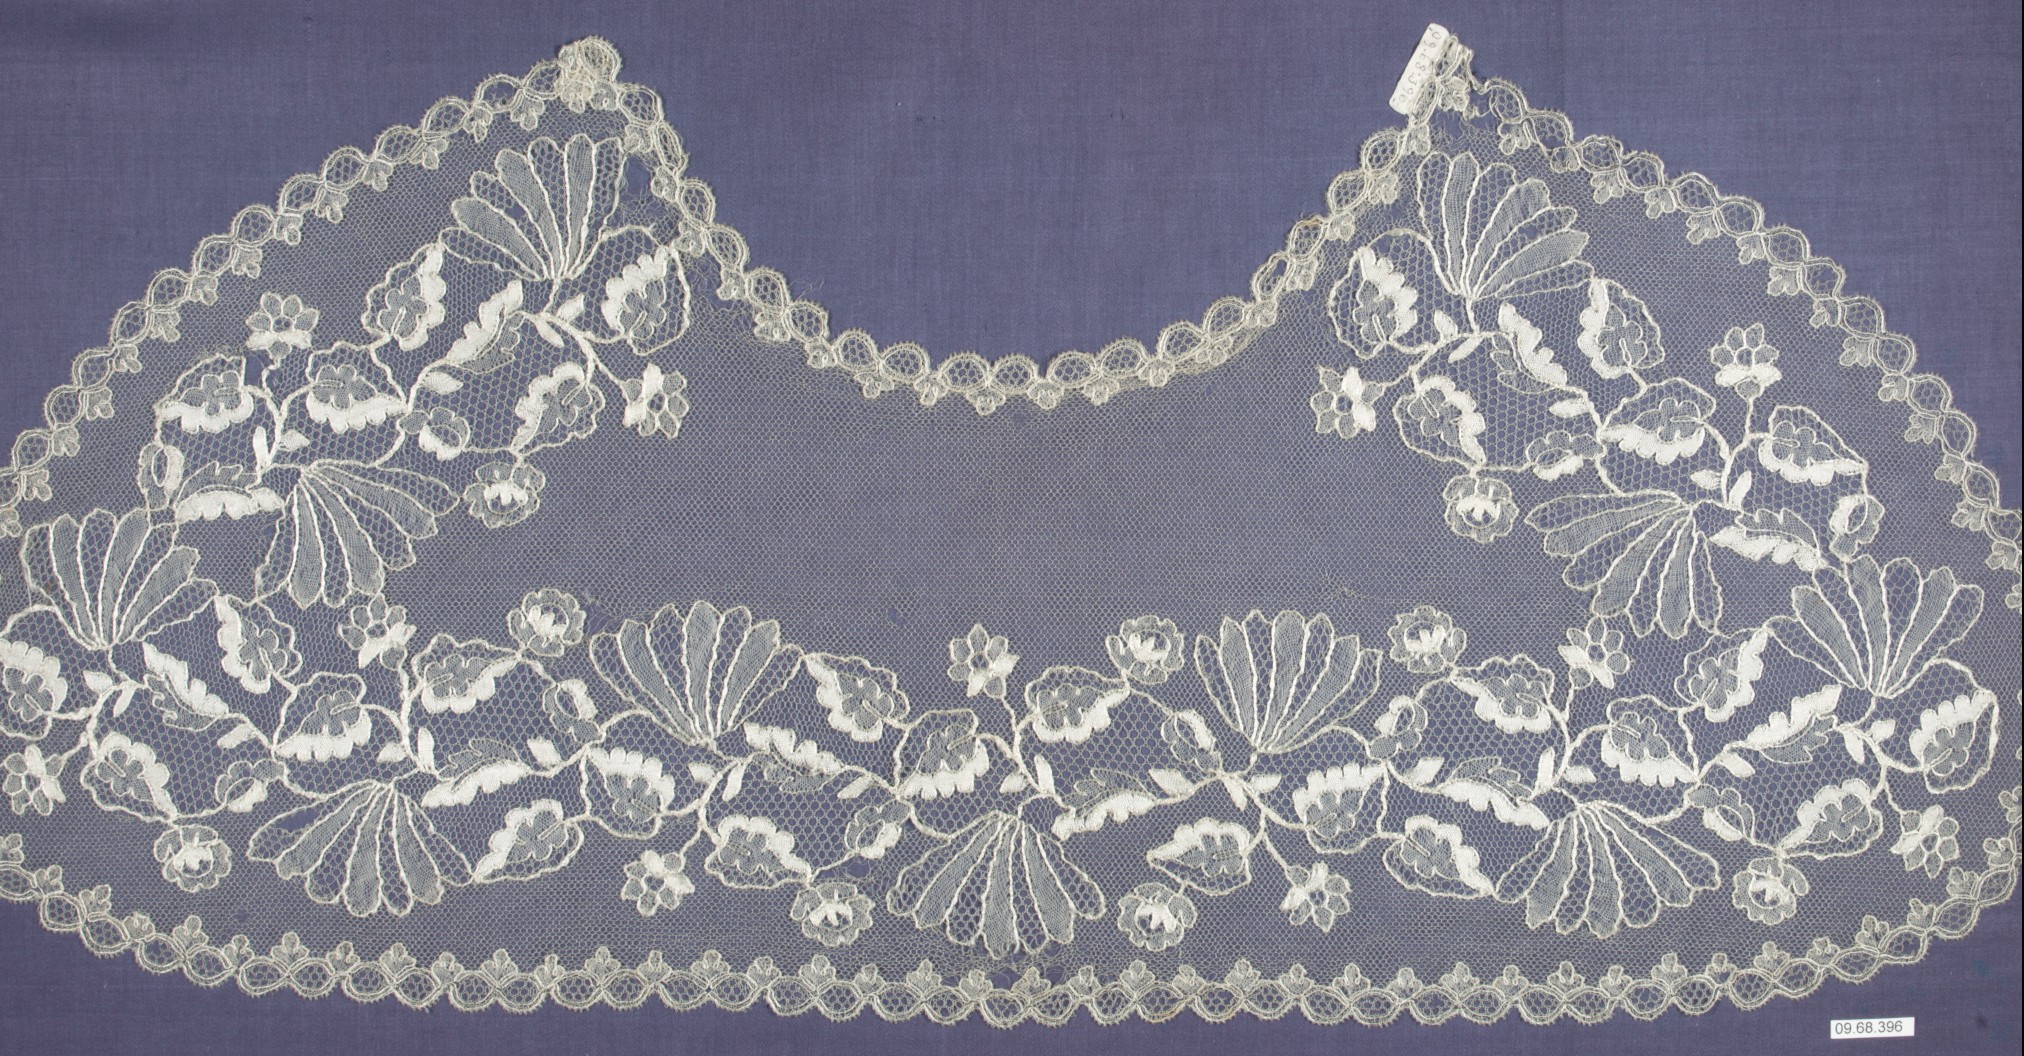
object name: collar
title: Silk bobbin lace collar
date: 1801-1833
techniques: lace